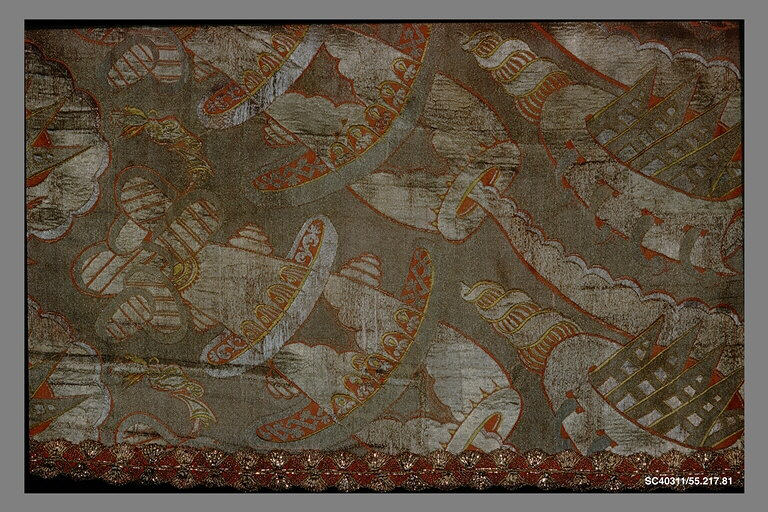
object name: piece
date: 1701-1750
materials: metal thread, silk